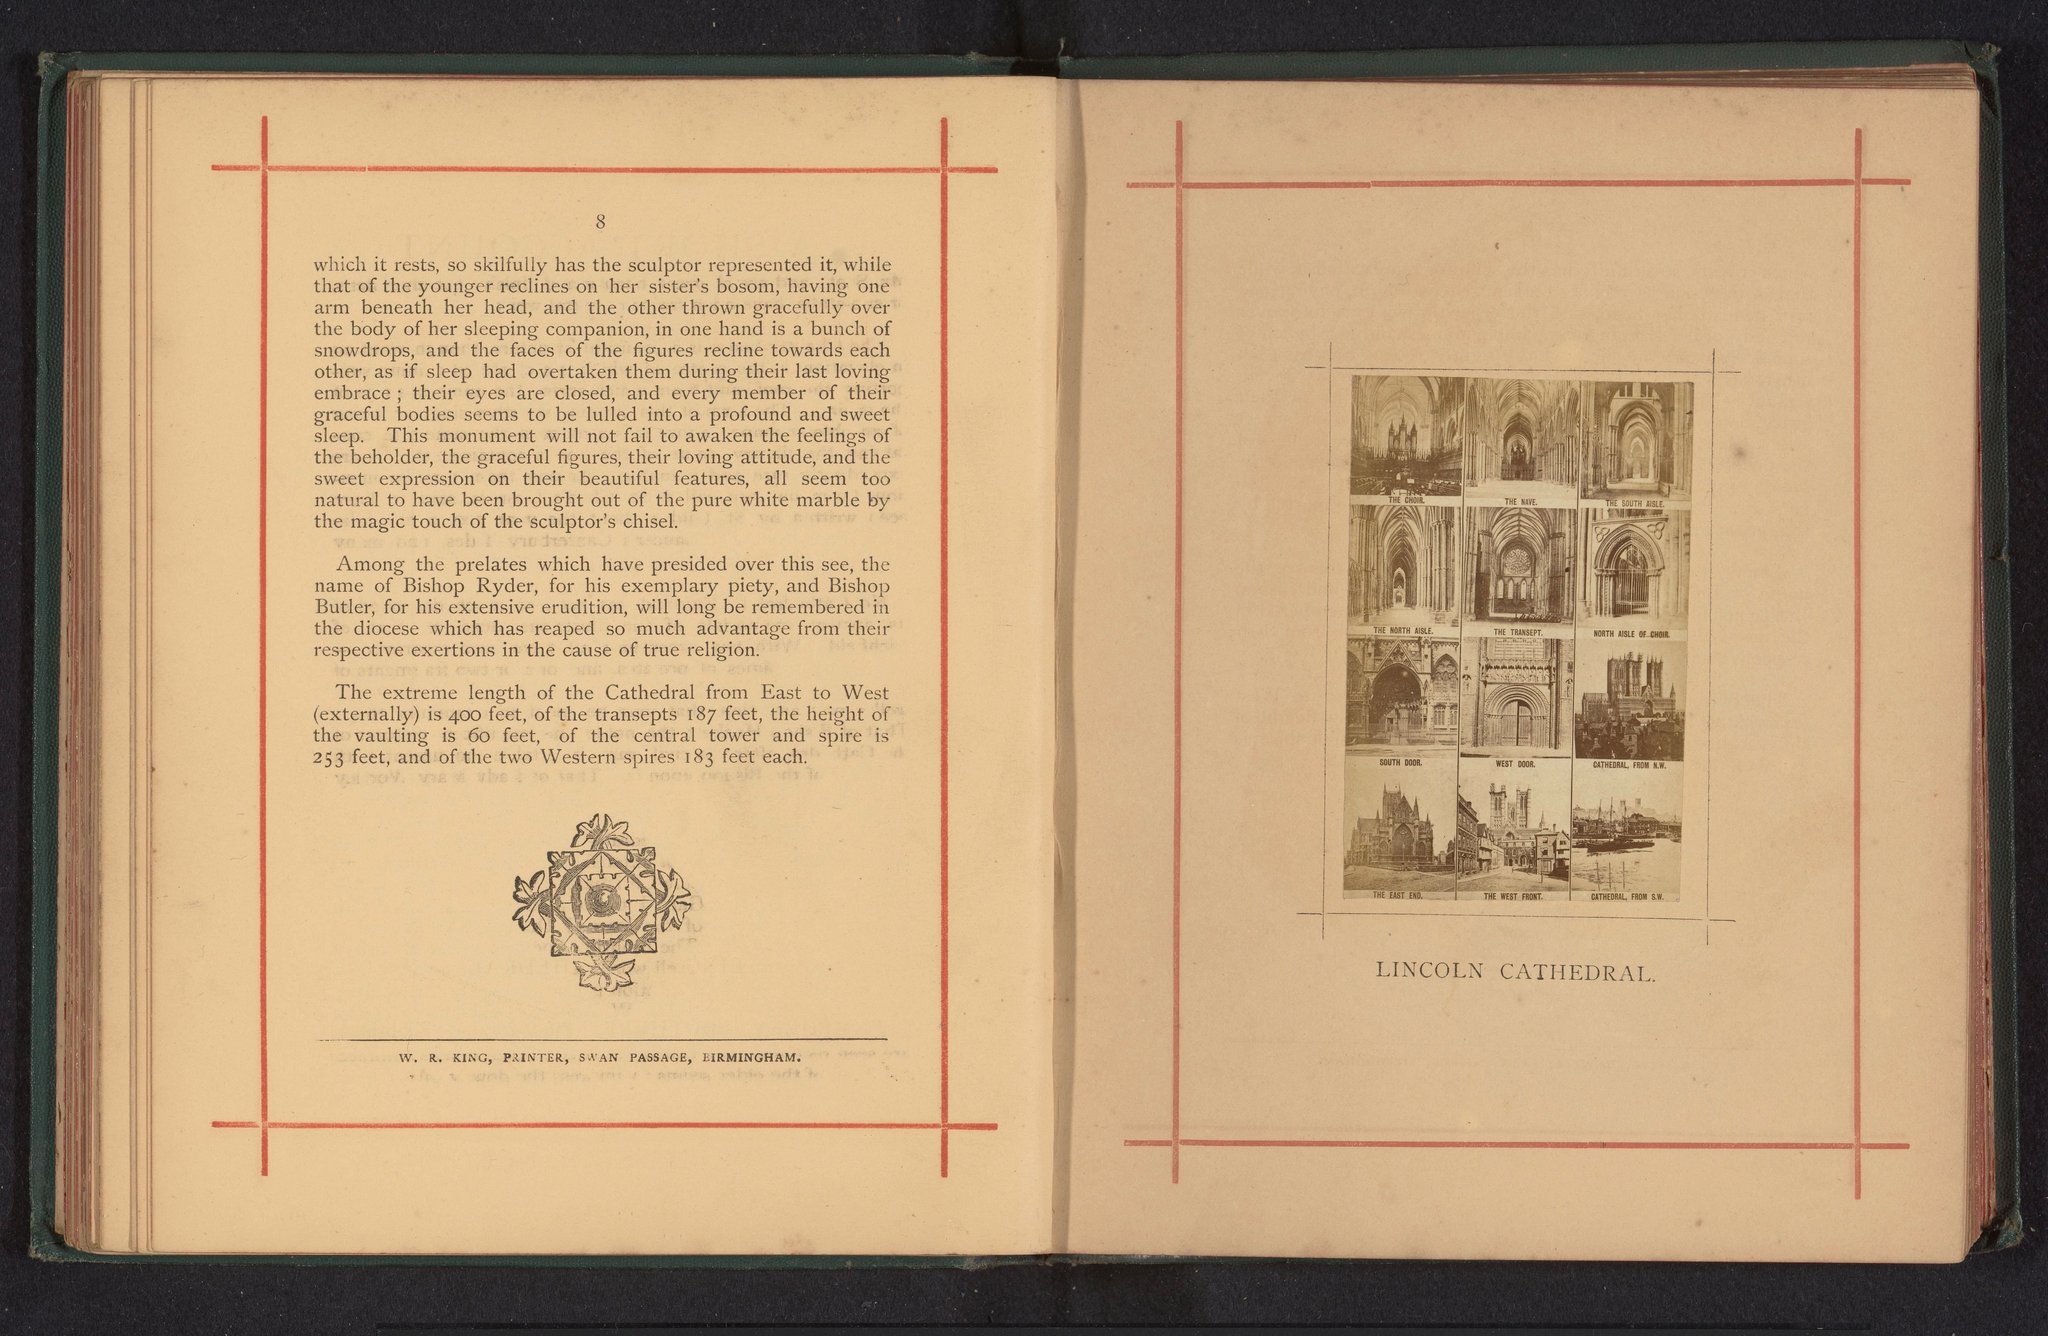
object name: photograph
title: Fotoreproductie van twaalf foto's van de kathedraal van Lincoln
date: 1870-1880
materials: photographic support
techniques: albumen print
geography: lincoln cathedral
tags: church (exterior), parts of church interior: nave, parts of church interior: choir, parts of church interior: chapel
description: Van boven naar beneden en van links naar rechts: het koor, het schip, tweemaal een zijbeuk, het transept, een zijbeuk van het koor, de zuidelijke deur, de westelijke deur, viermaal een gezicht op de kathedraal.